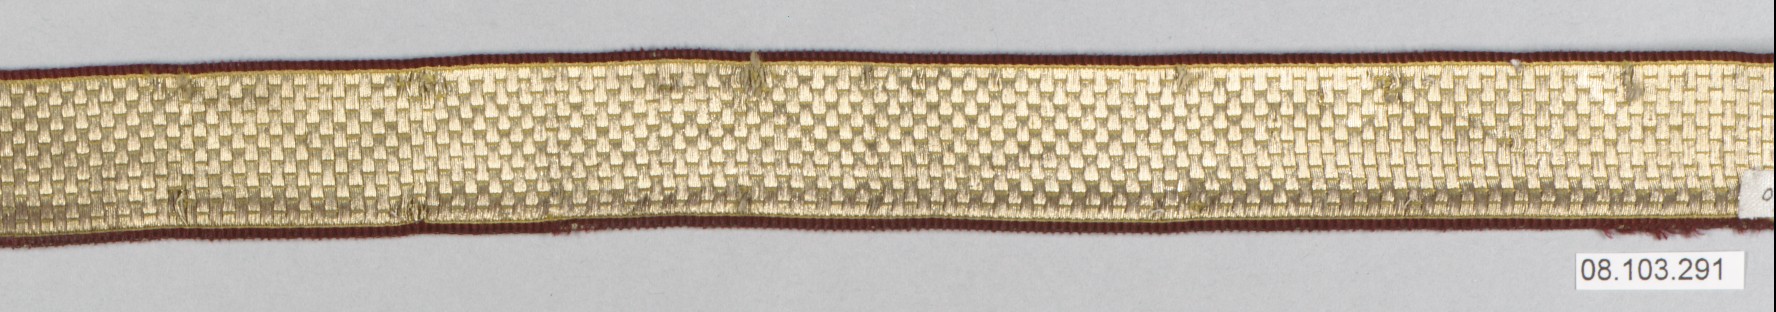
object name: galloon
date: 1601-1800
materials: metal thread, silk